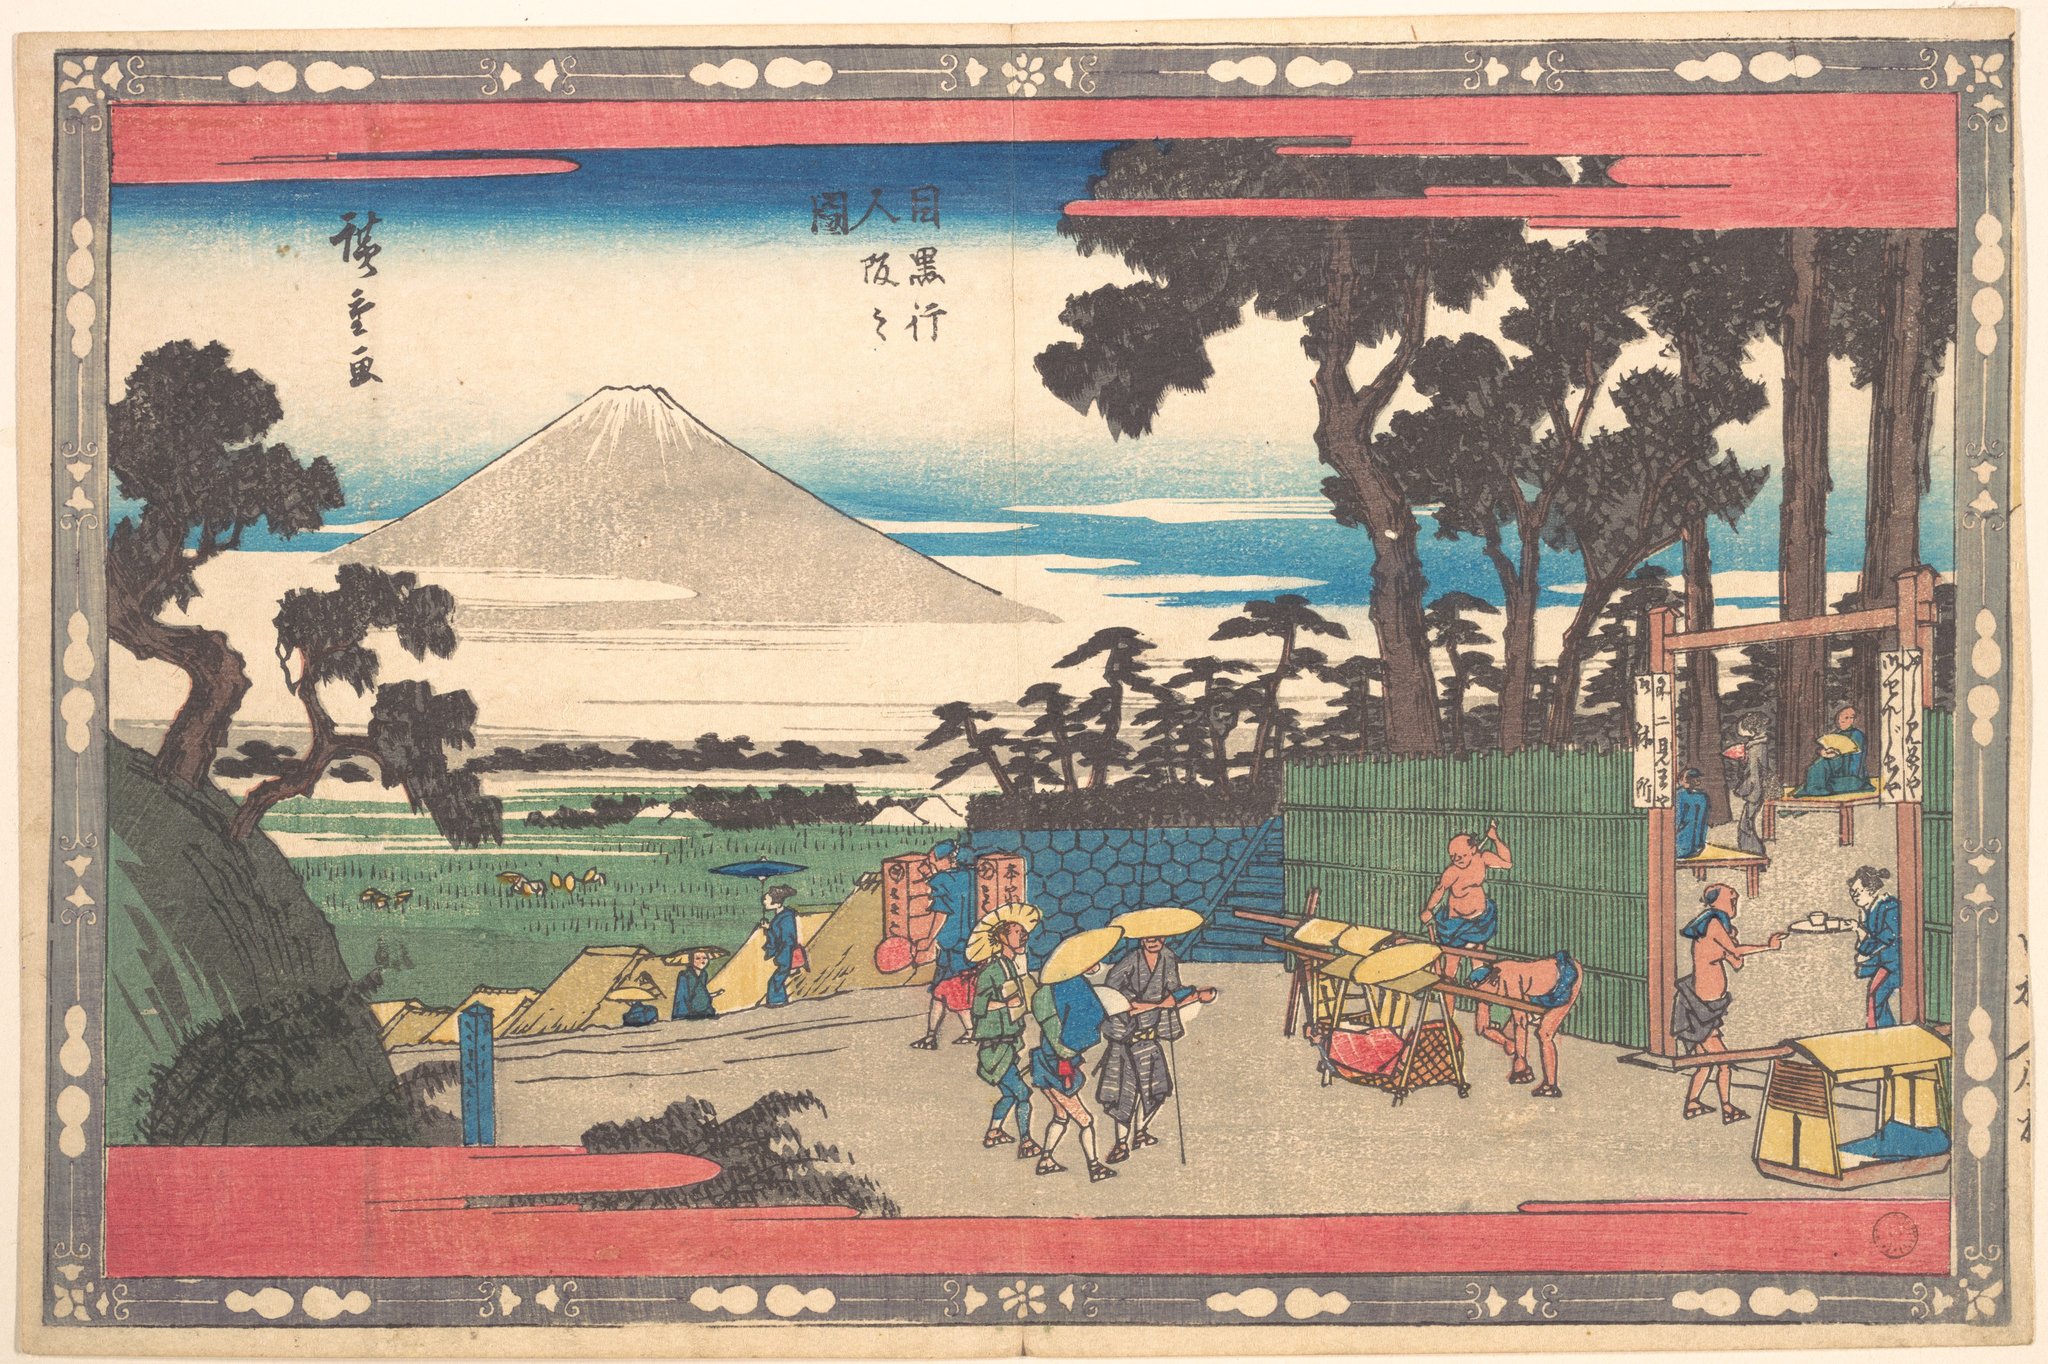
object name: print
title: Meguro Gionin Zaka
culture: japanese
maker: utagawa hiroshige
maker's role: artist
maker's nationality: japanese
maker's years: 1797-1858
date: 1797-1858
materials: ink, paper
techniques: woodblock print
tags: human figures,inns,mountains